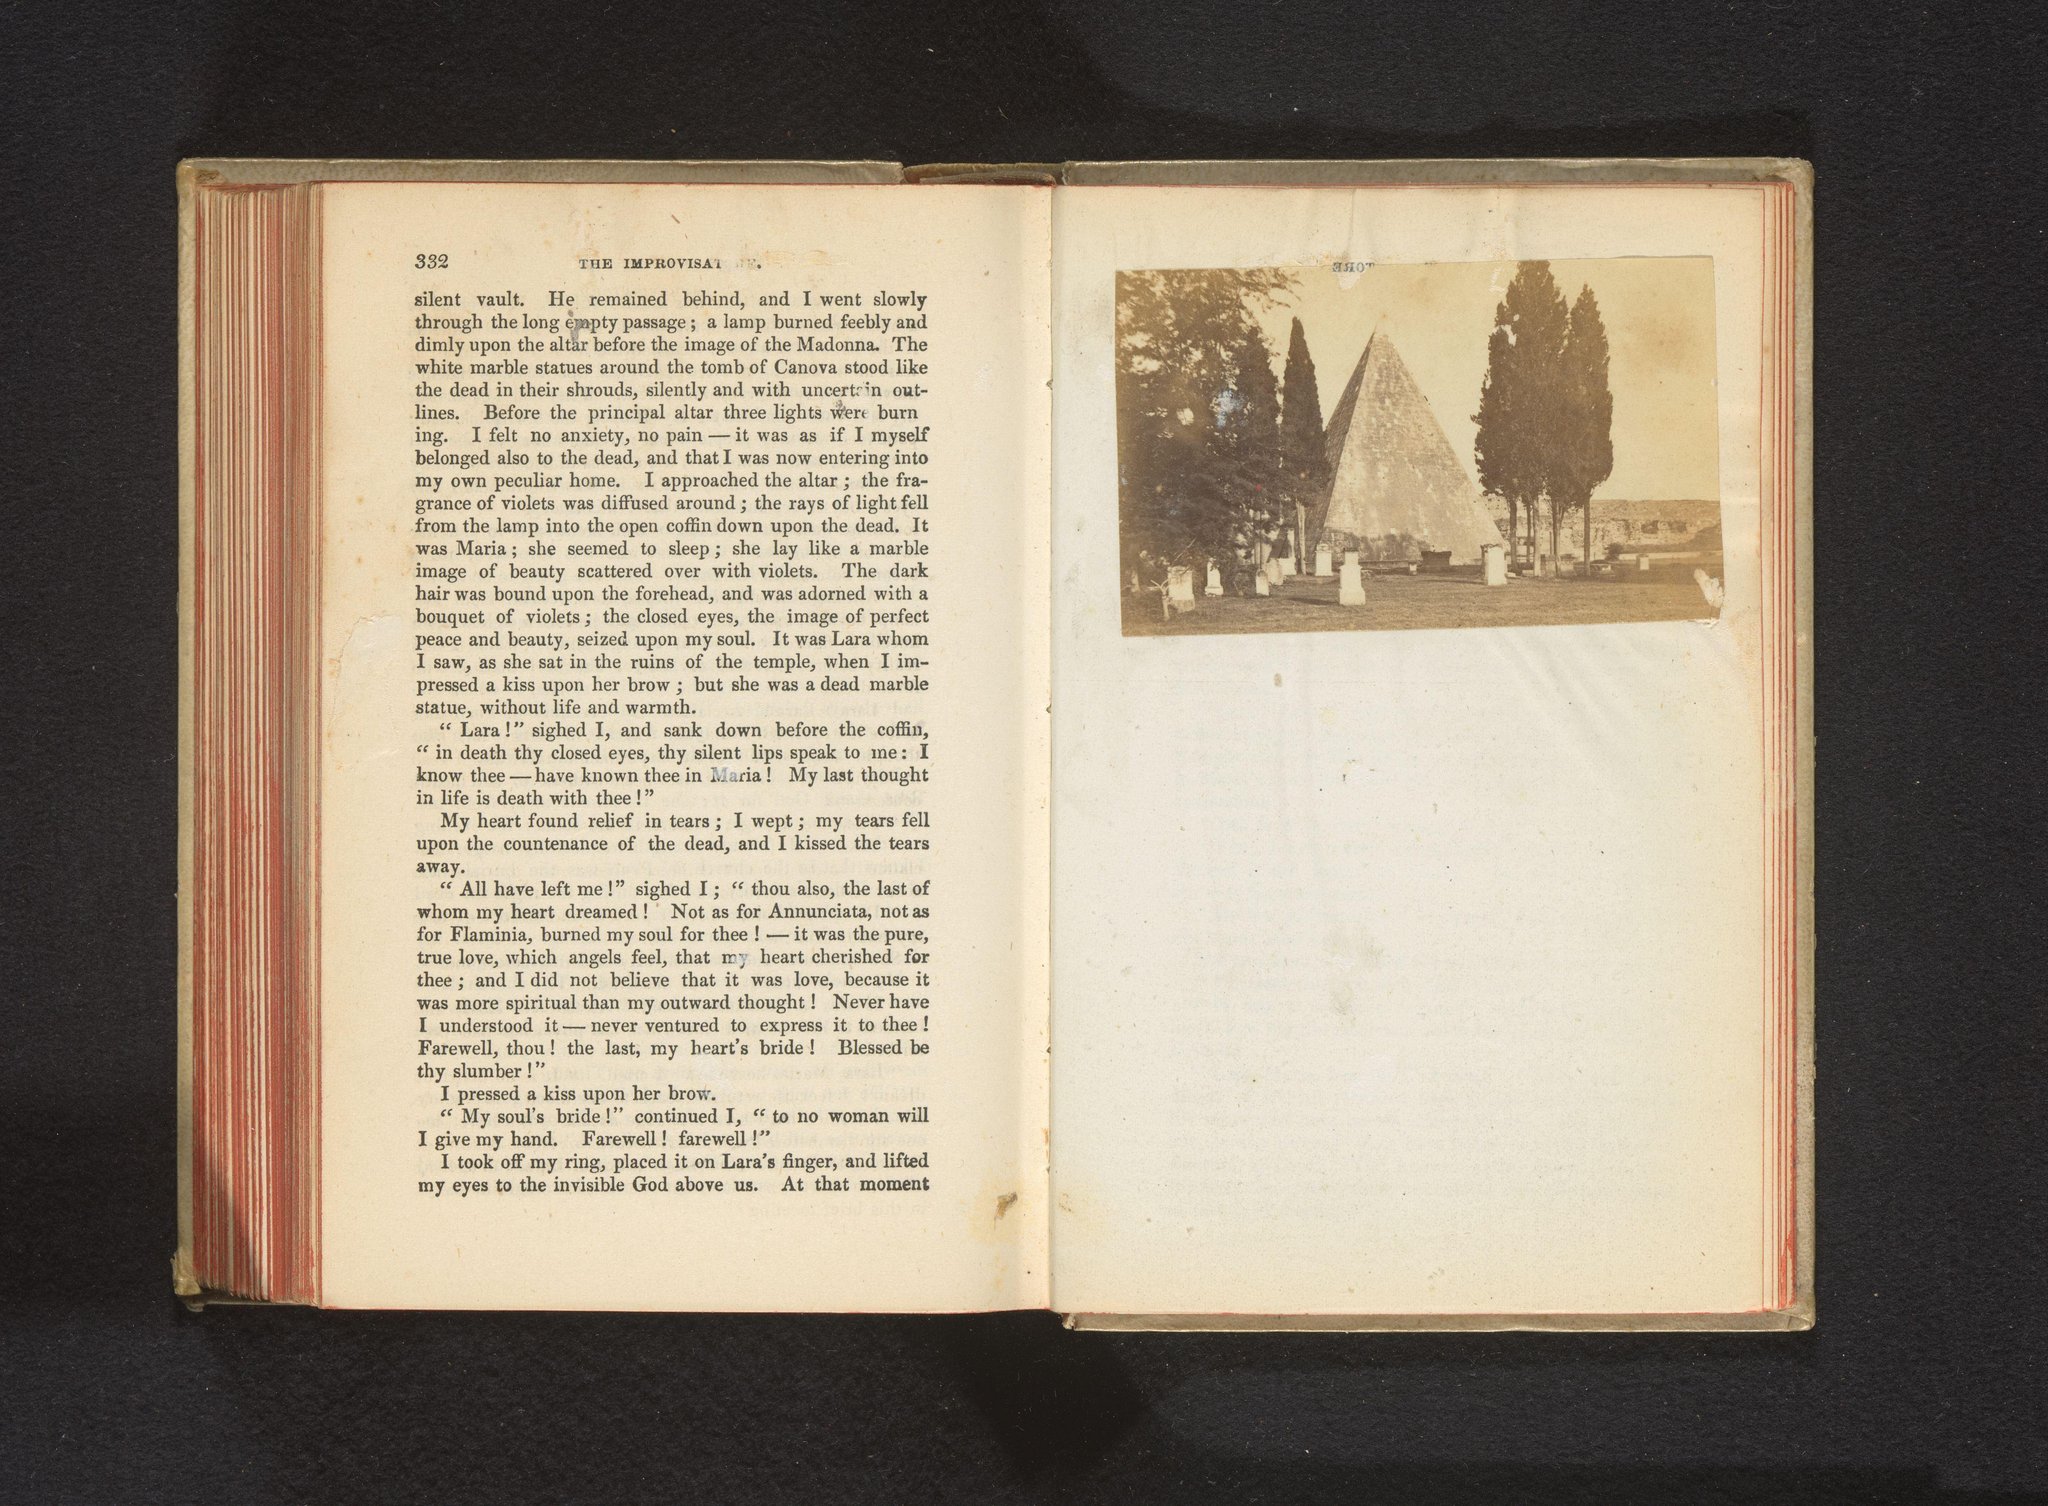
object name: page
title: Piramide van Cestius te Rome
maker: Anonymous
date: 1863-1873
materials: photographic support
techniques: albumen print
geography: rome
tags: pyramid (marking grave)